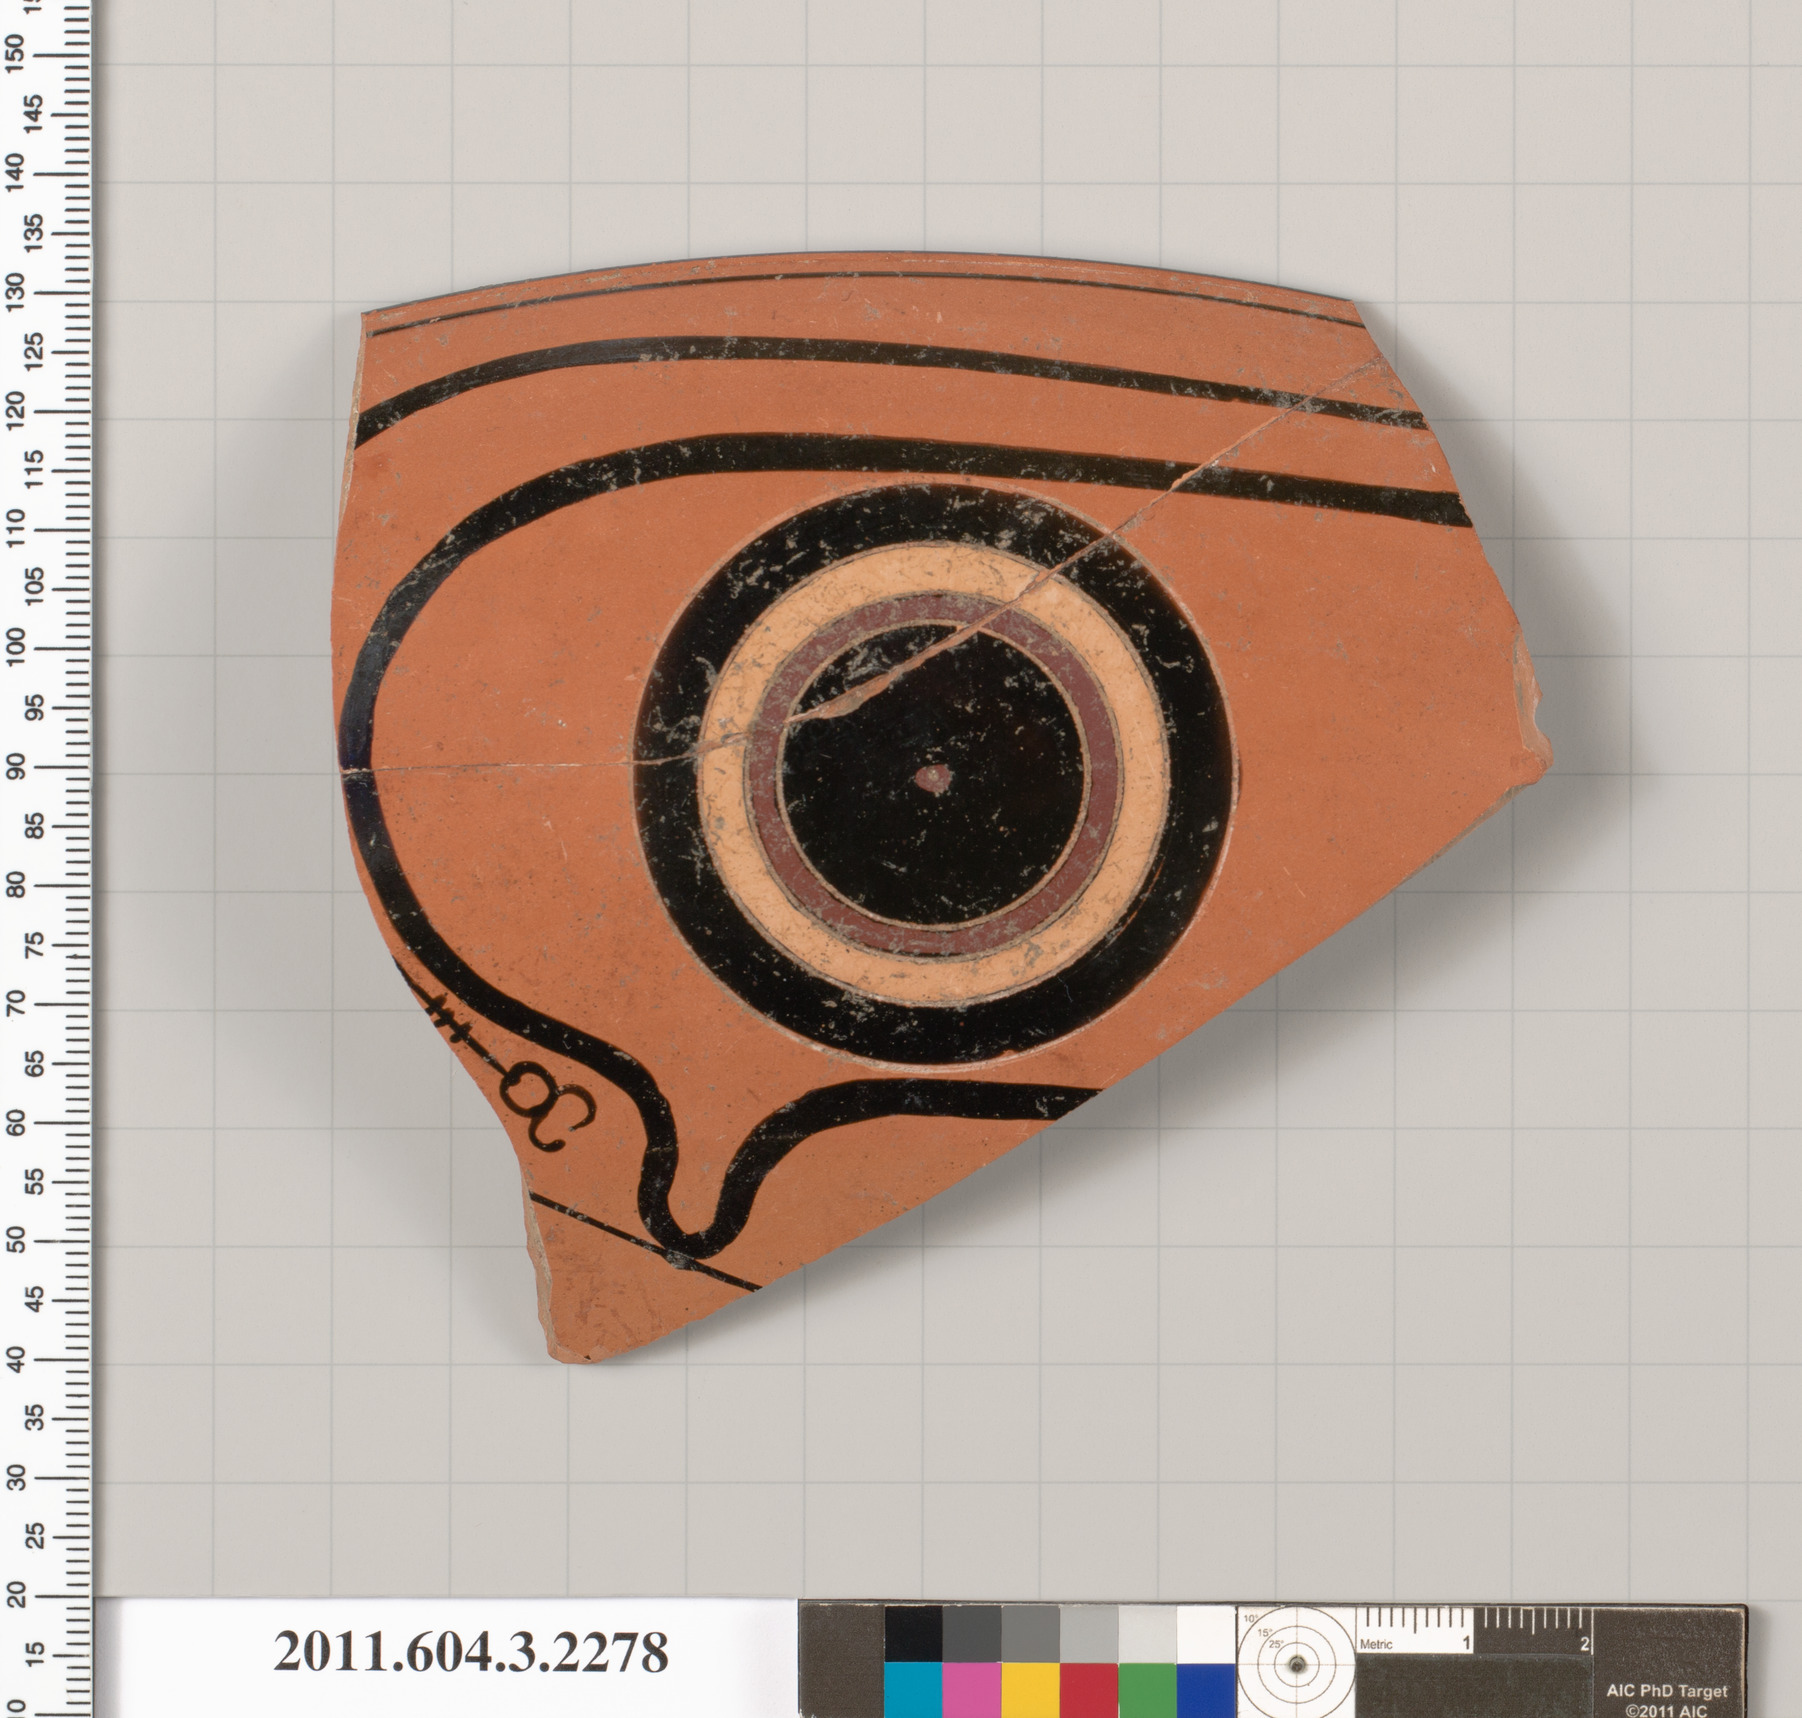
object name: kylix fragment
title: Terracotta rim fragment of a kylix: eye-cup (drinking cup)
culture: greek, attic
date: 520-510 BCE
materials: terracotta